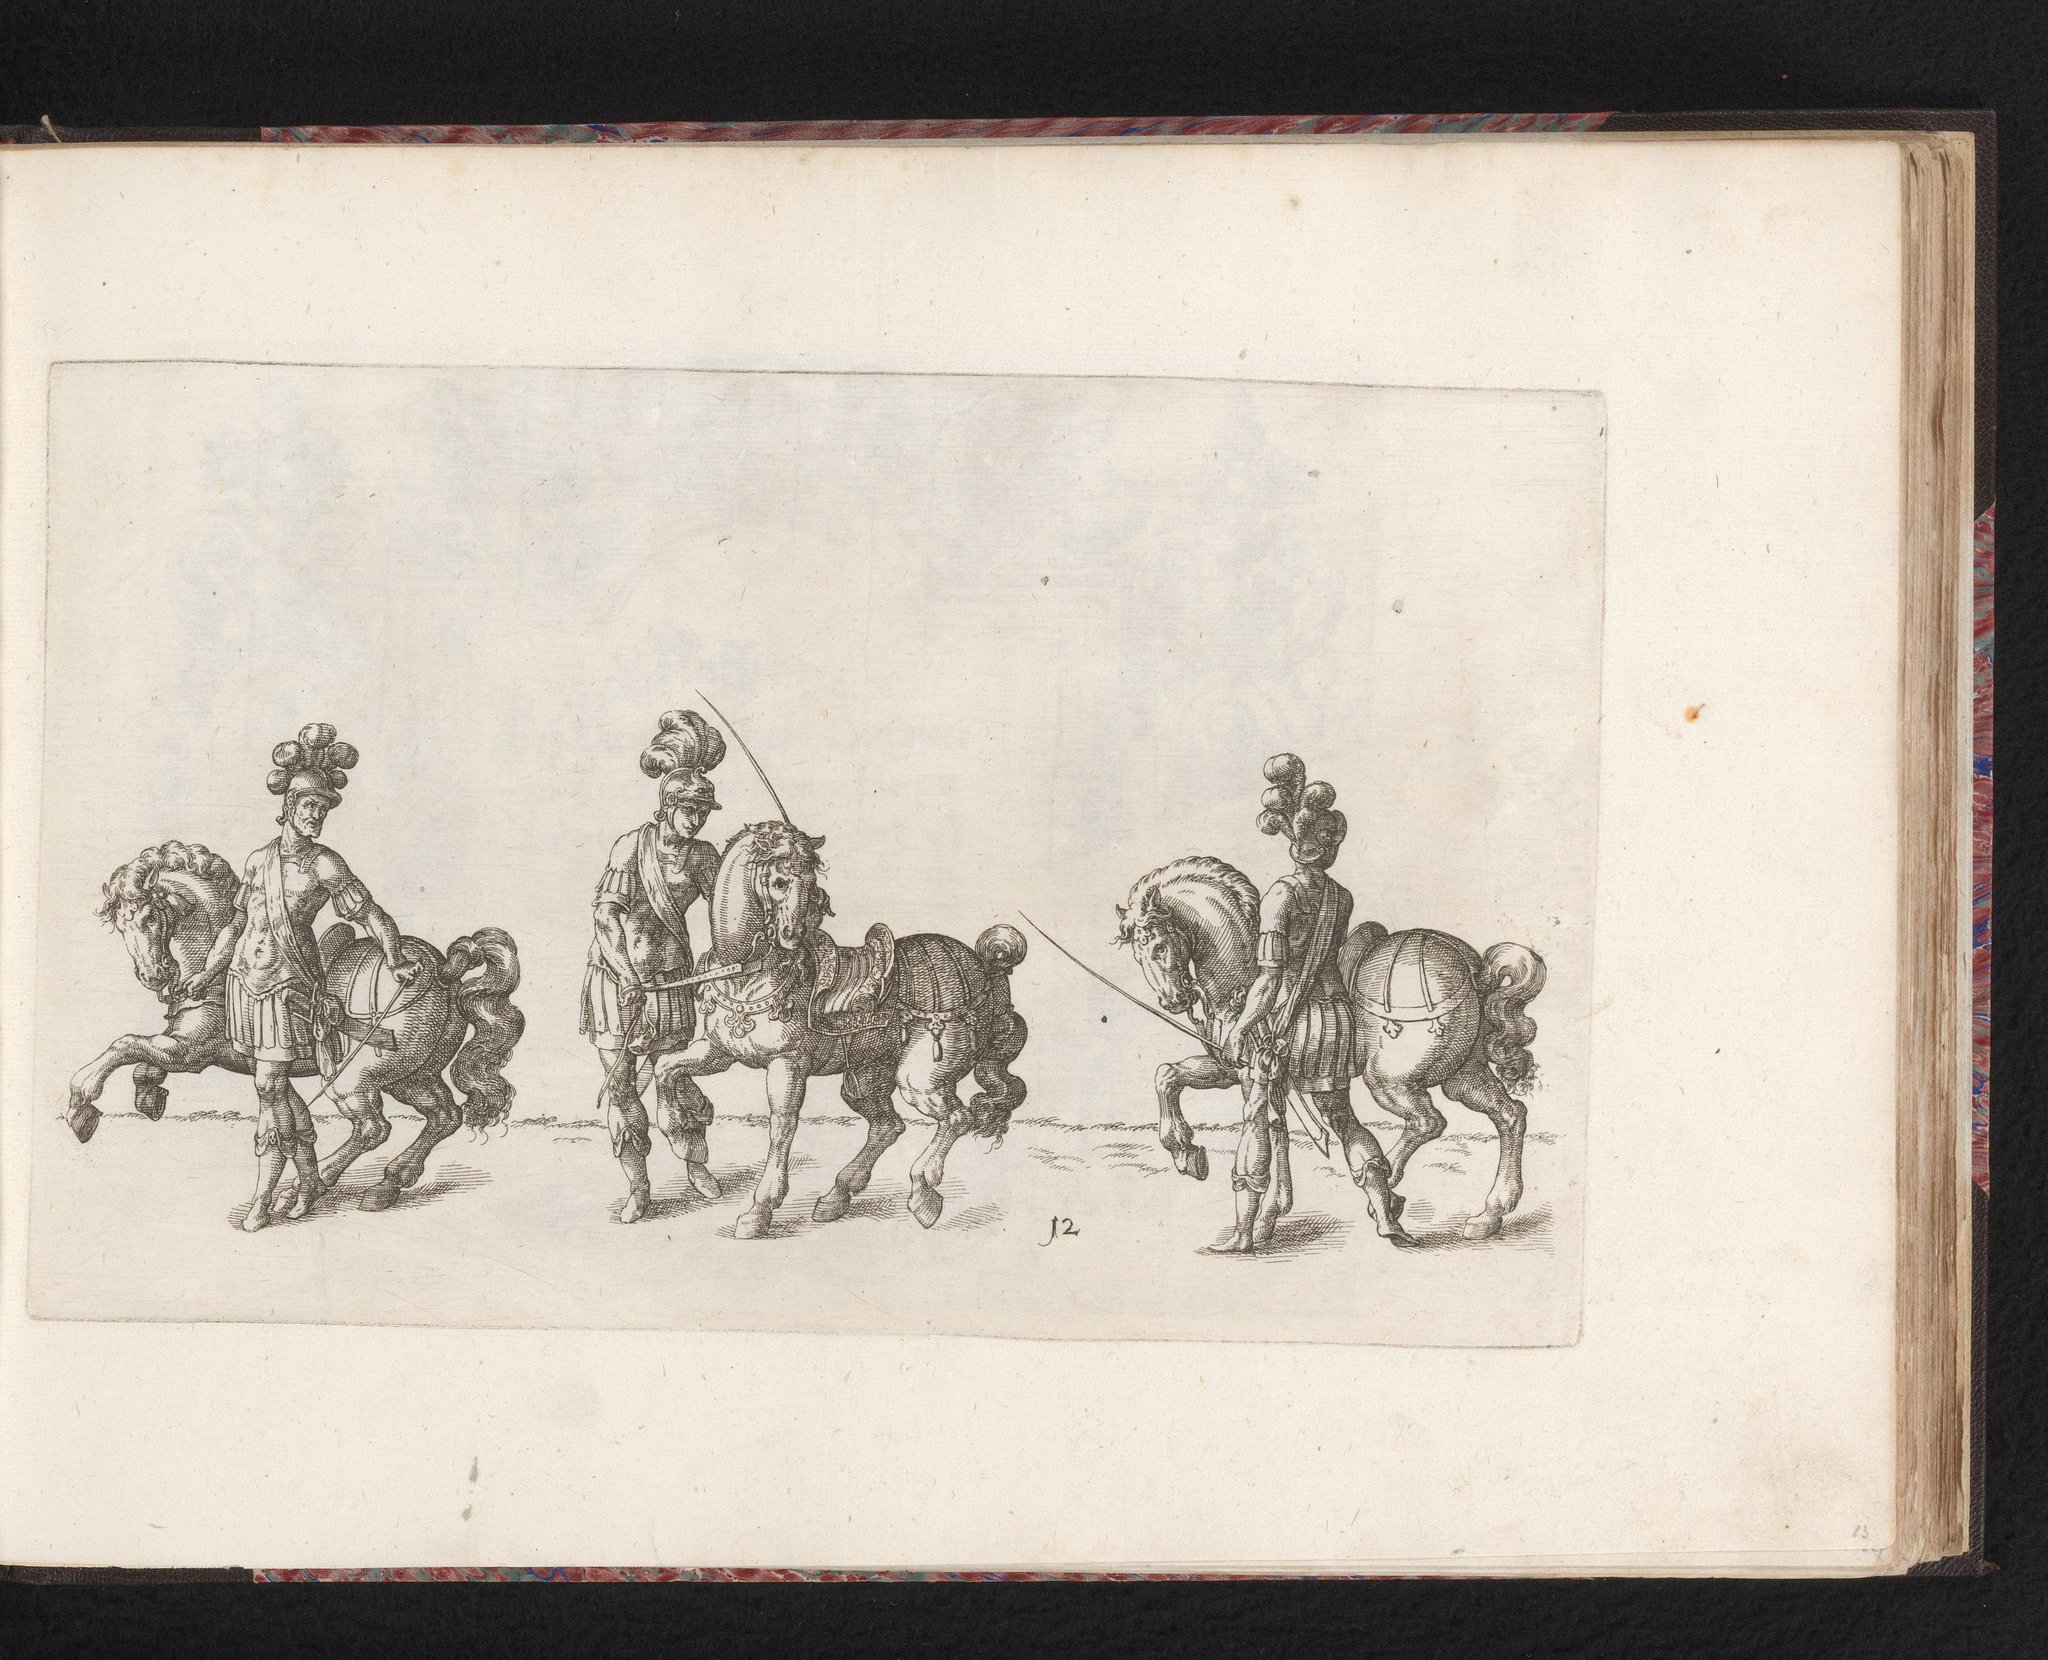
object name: album leaf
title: Aigentliche wahrhaffte Delineation unnd Abbildung aller fürstlichen Auffzüg und Rütterspilen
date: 1618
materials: paper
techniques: etching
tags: private soldier (+ cavalry, horsemen), performance in the open air (pleasure fair)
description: Genummerd: 11. Deze prent maakt deel uit van een album.